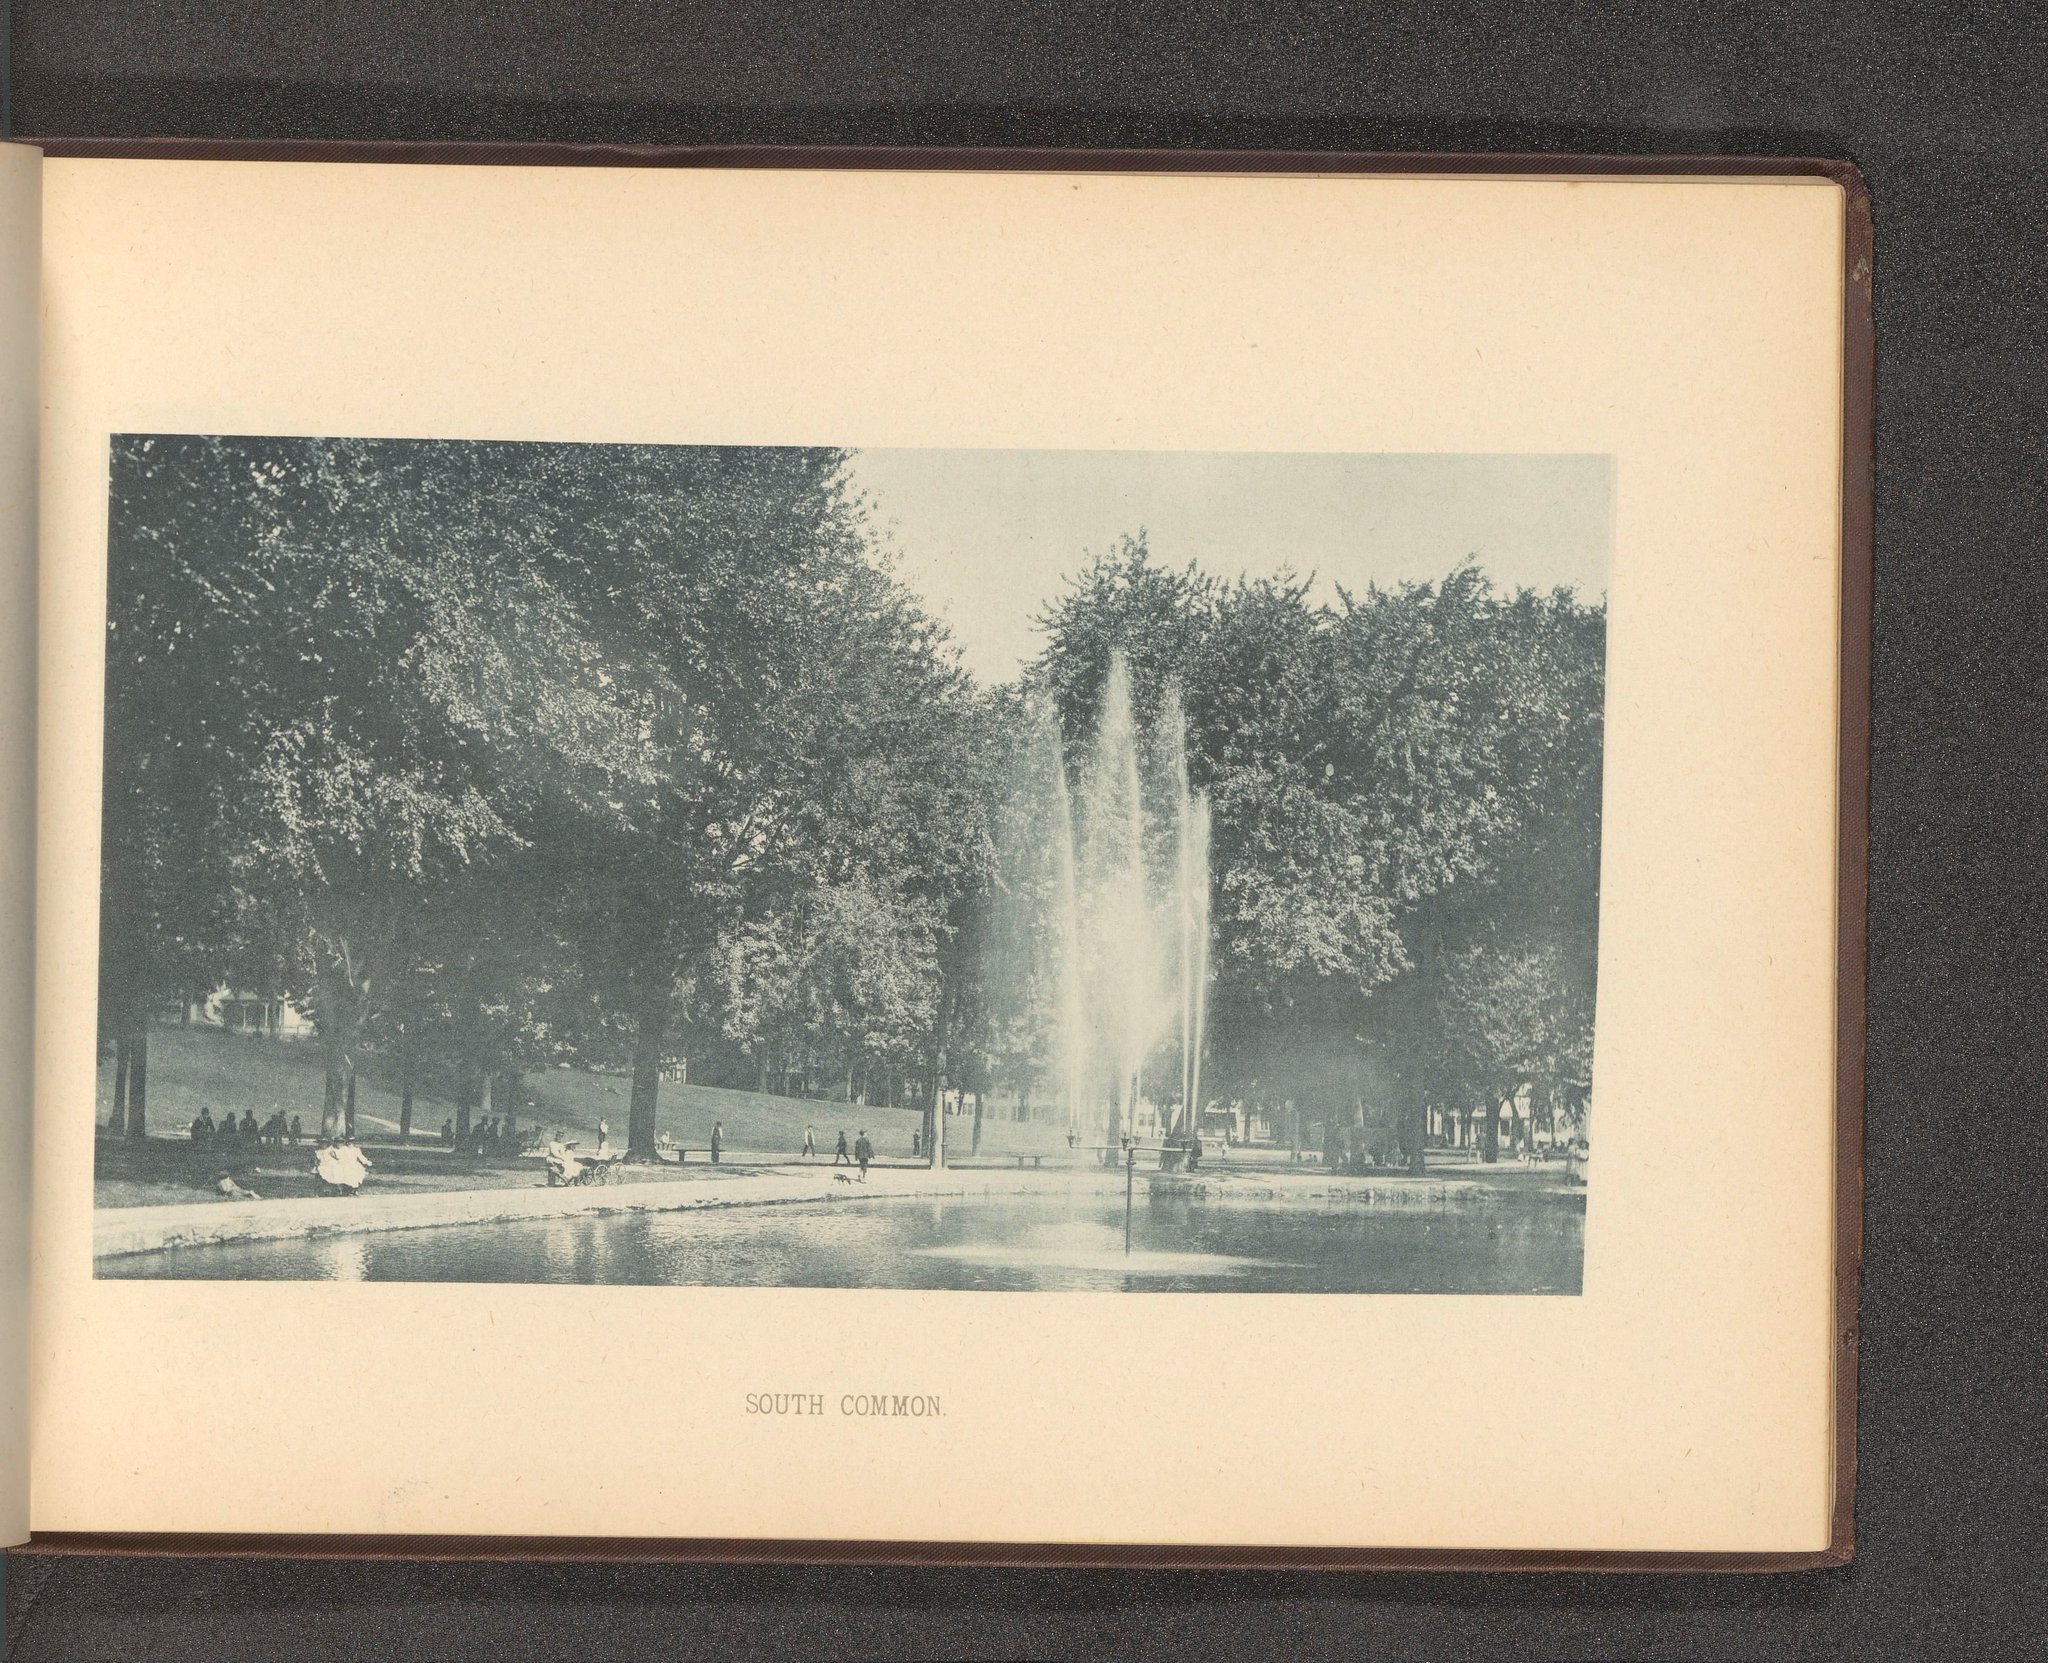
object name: photomechanical print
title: Gezicht op een park met vijver te Lowell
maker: Anonymous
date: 1887-1892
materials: paper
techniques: photograph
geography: lowell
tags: pond, pool, ornamental fountain, public gardens, park